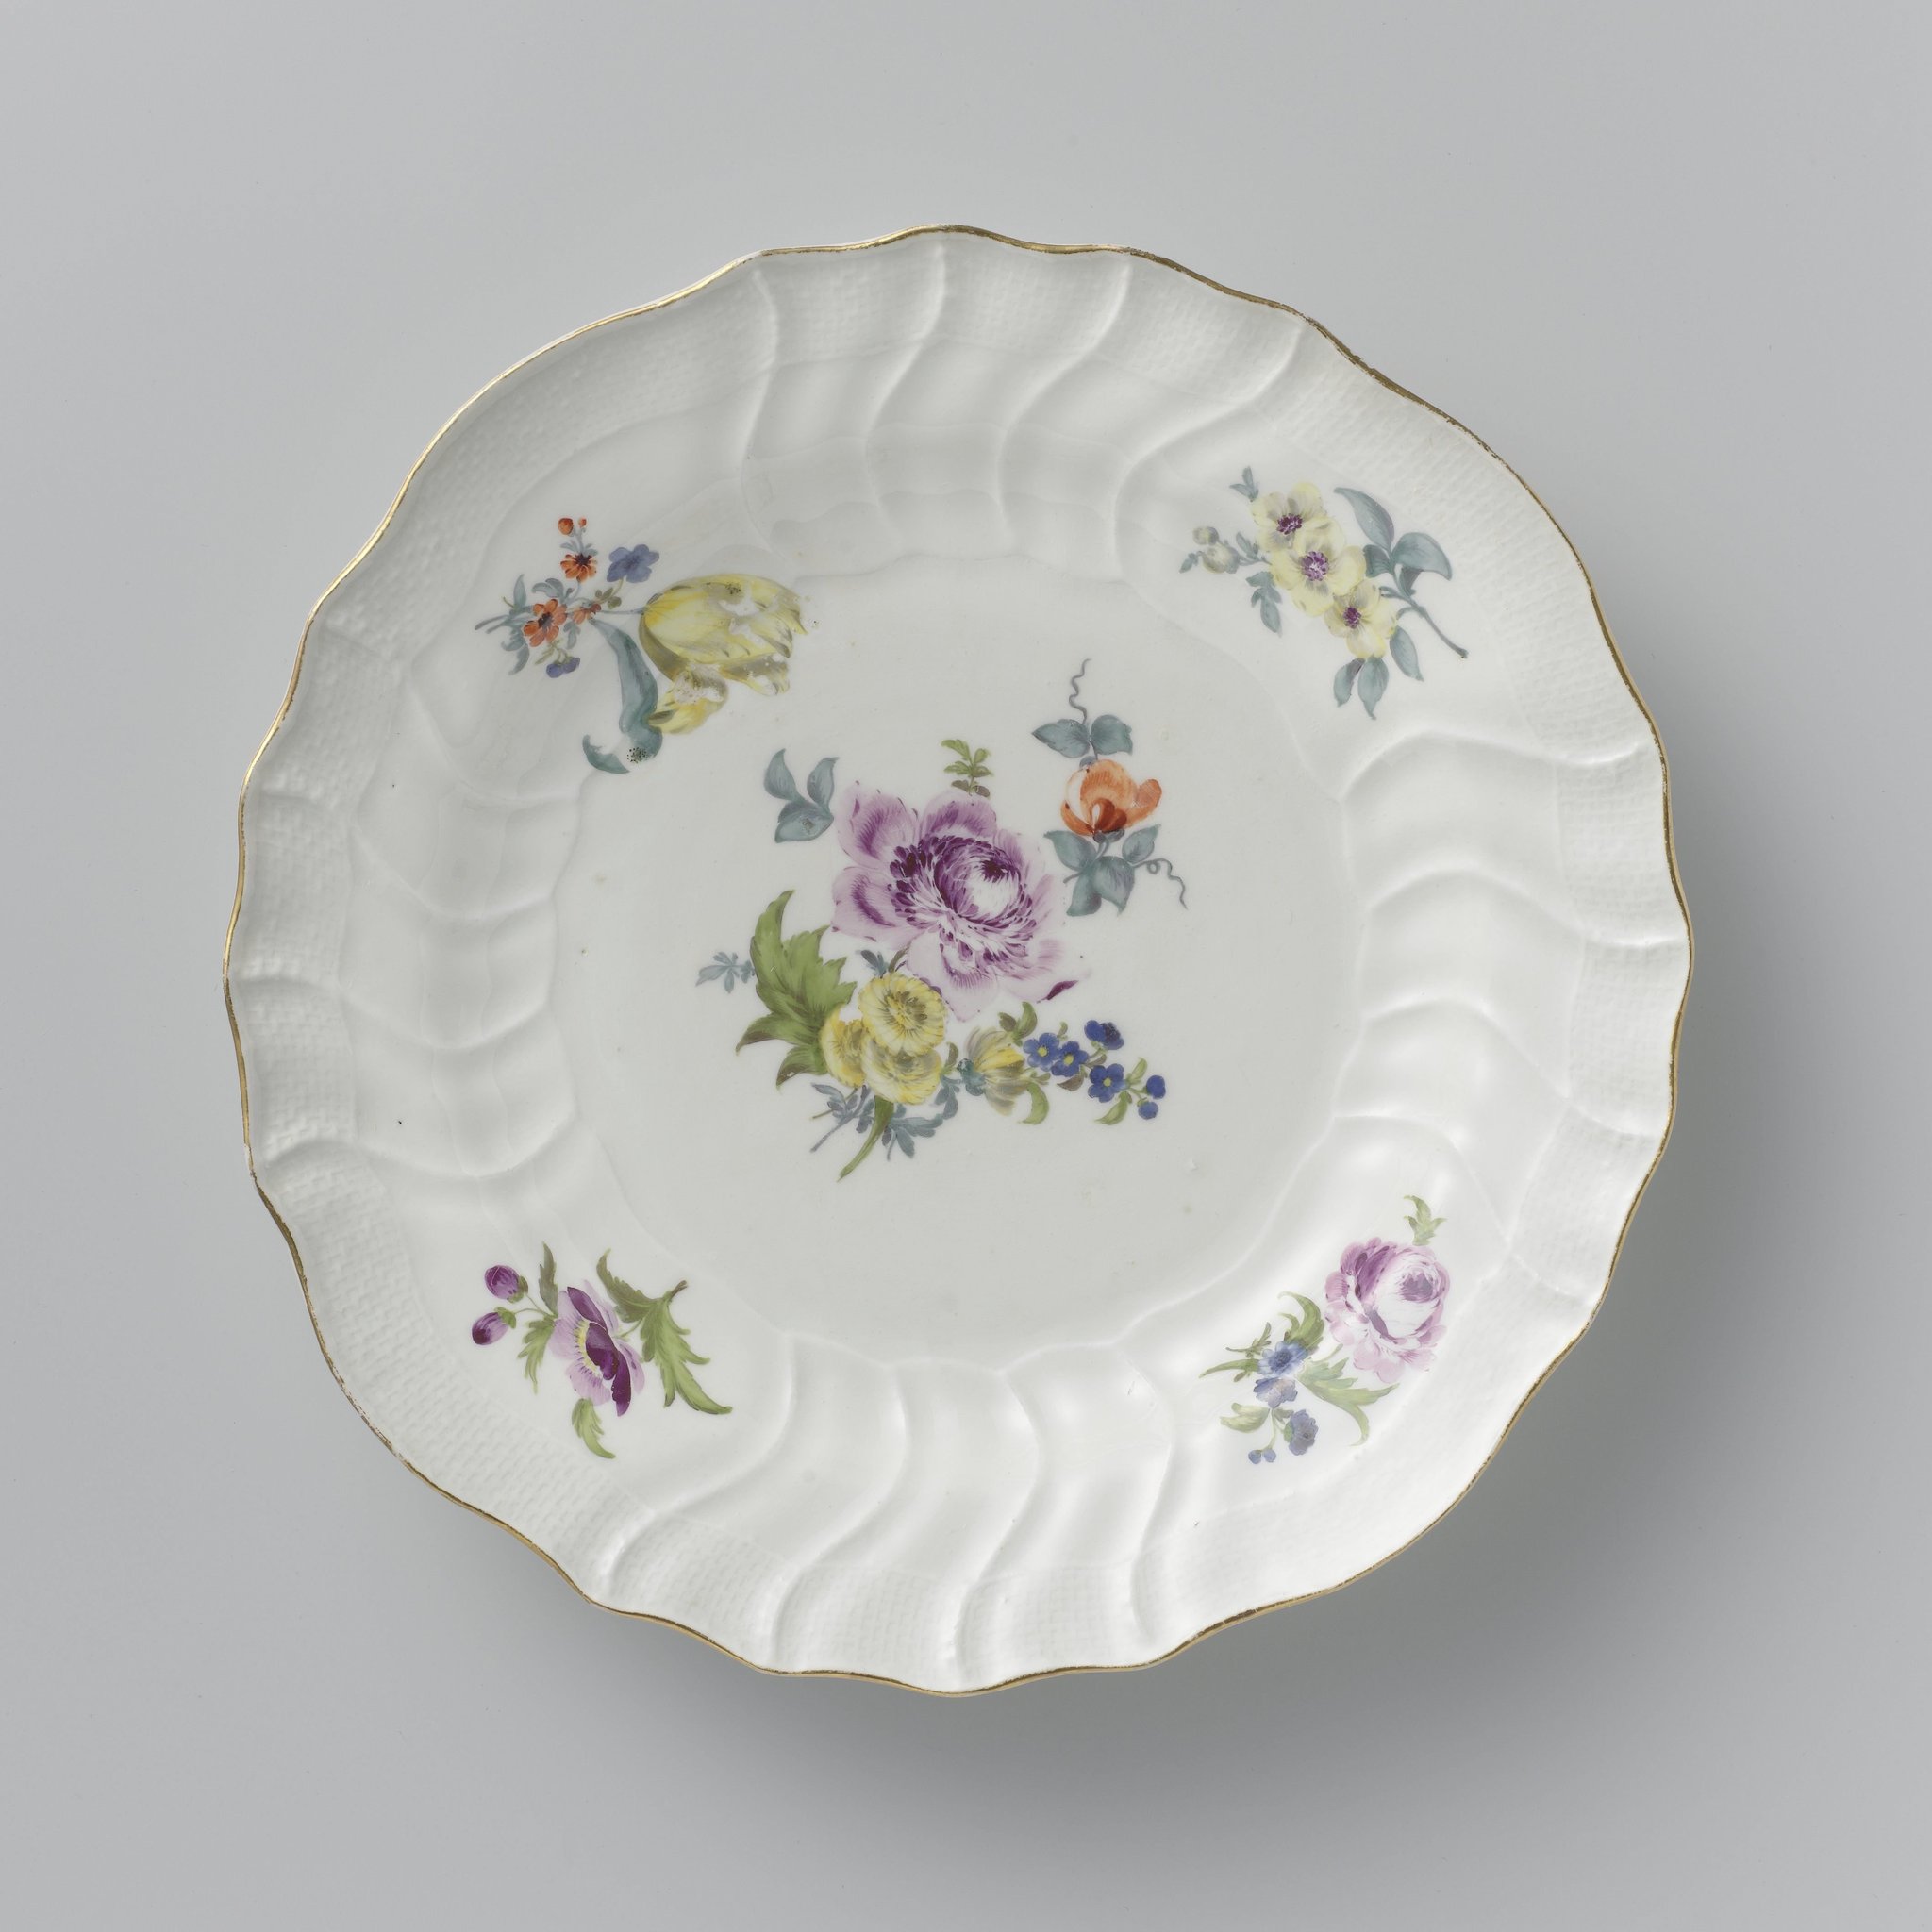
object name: plate dish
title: Bord, veelkleurig beschilderd met Deutsche Blumen, insekten en vruchten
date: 1750-1760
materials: porcelain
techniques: painted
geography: meissen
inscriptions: factory mark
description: Rond bord van beschilderd porselein. Het bord is beschilderd met Deutsche Blumen, insekten en vruchten. De rand is in reliëf versierd met het Neuozier-patroon. Het bord is gemerkt en hoort bij een servies (BK-17474-1 t/m BK-17474-253).